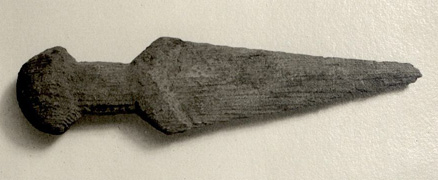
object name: model dagger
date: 1981-1640 BCE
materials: wood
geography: egypt